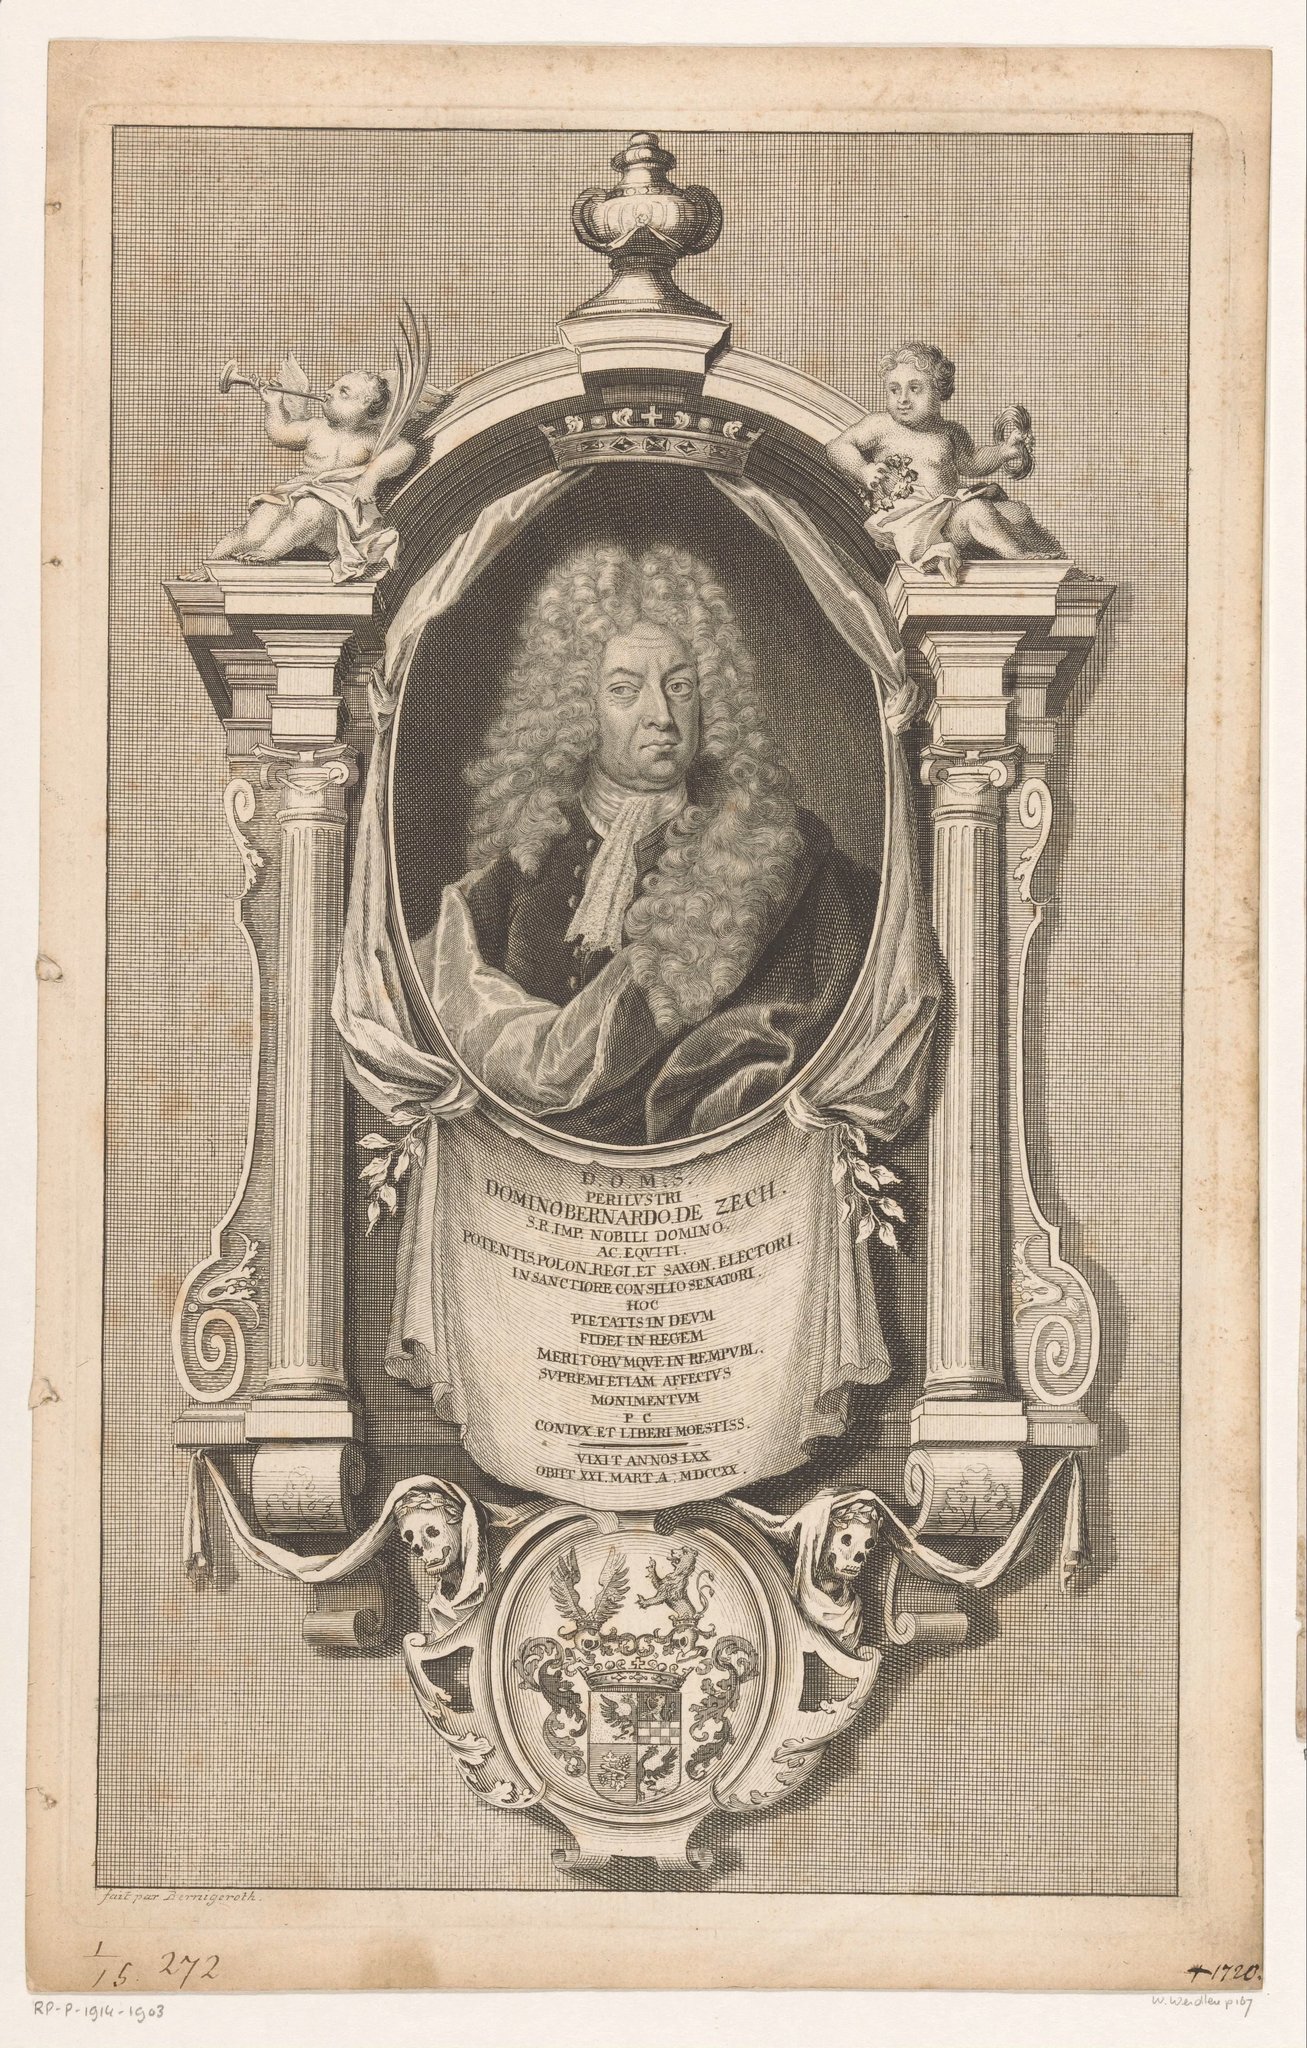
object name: print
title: Epitaaf met portret van Bernhard von Zech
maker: martin bernigeroth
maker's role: print maker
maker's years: 1670-1733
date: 1720-1733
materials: paper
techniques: engraving, etching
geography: leipzig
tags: historical persons, epitaph, armorial bearing, heraldry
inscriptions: collector's mark: Lugt 2228, collector's mark: Lugt 357